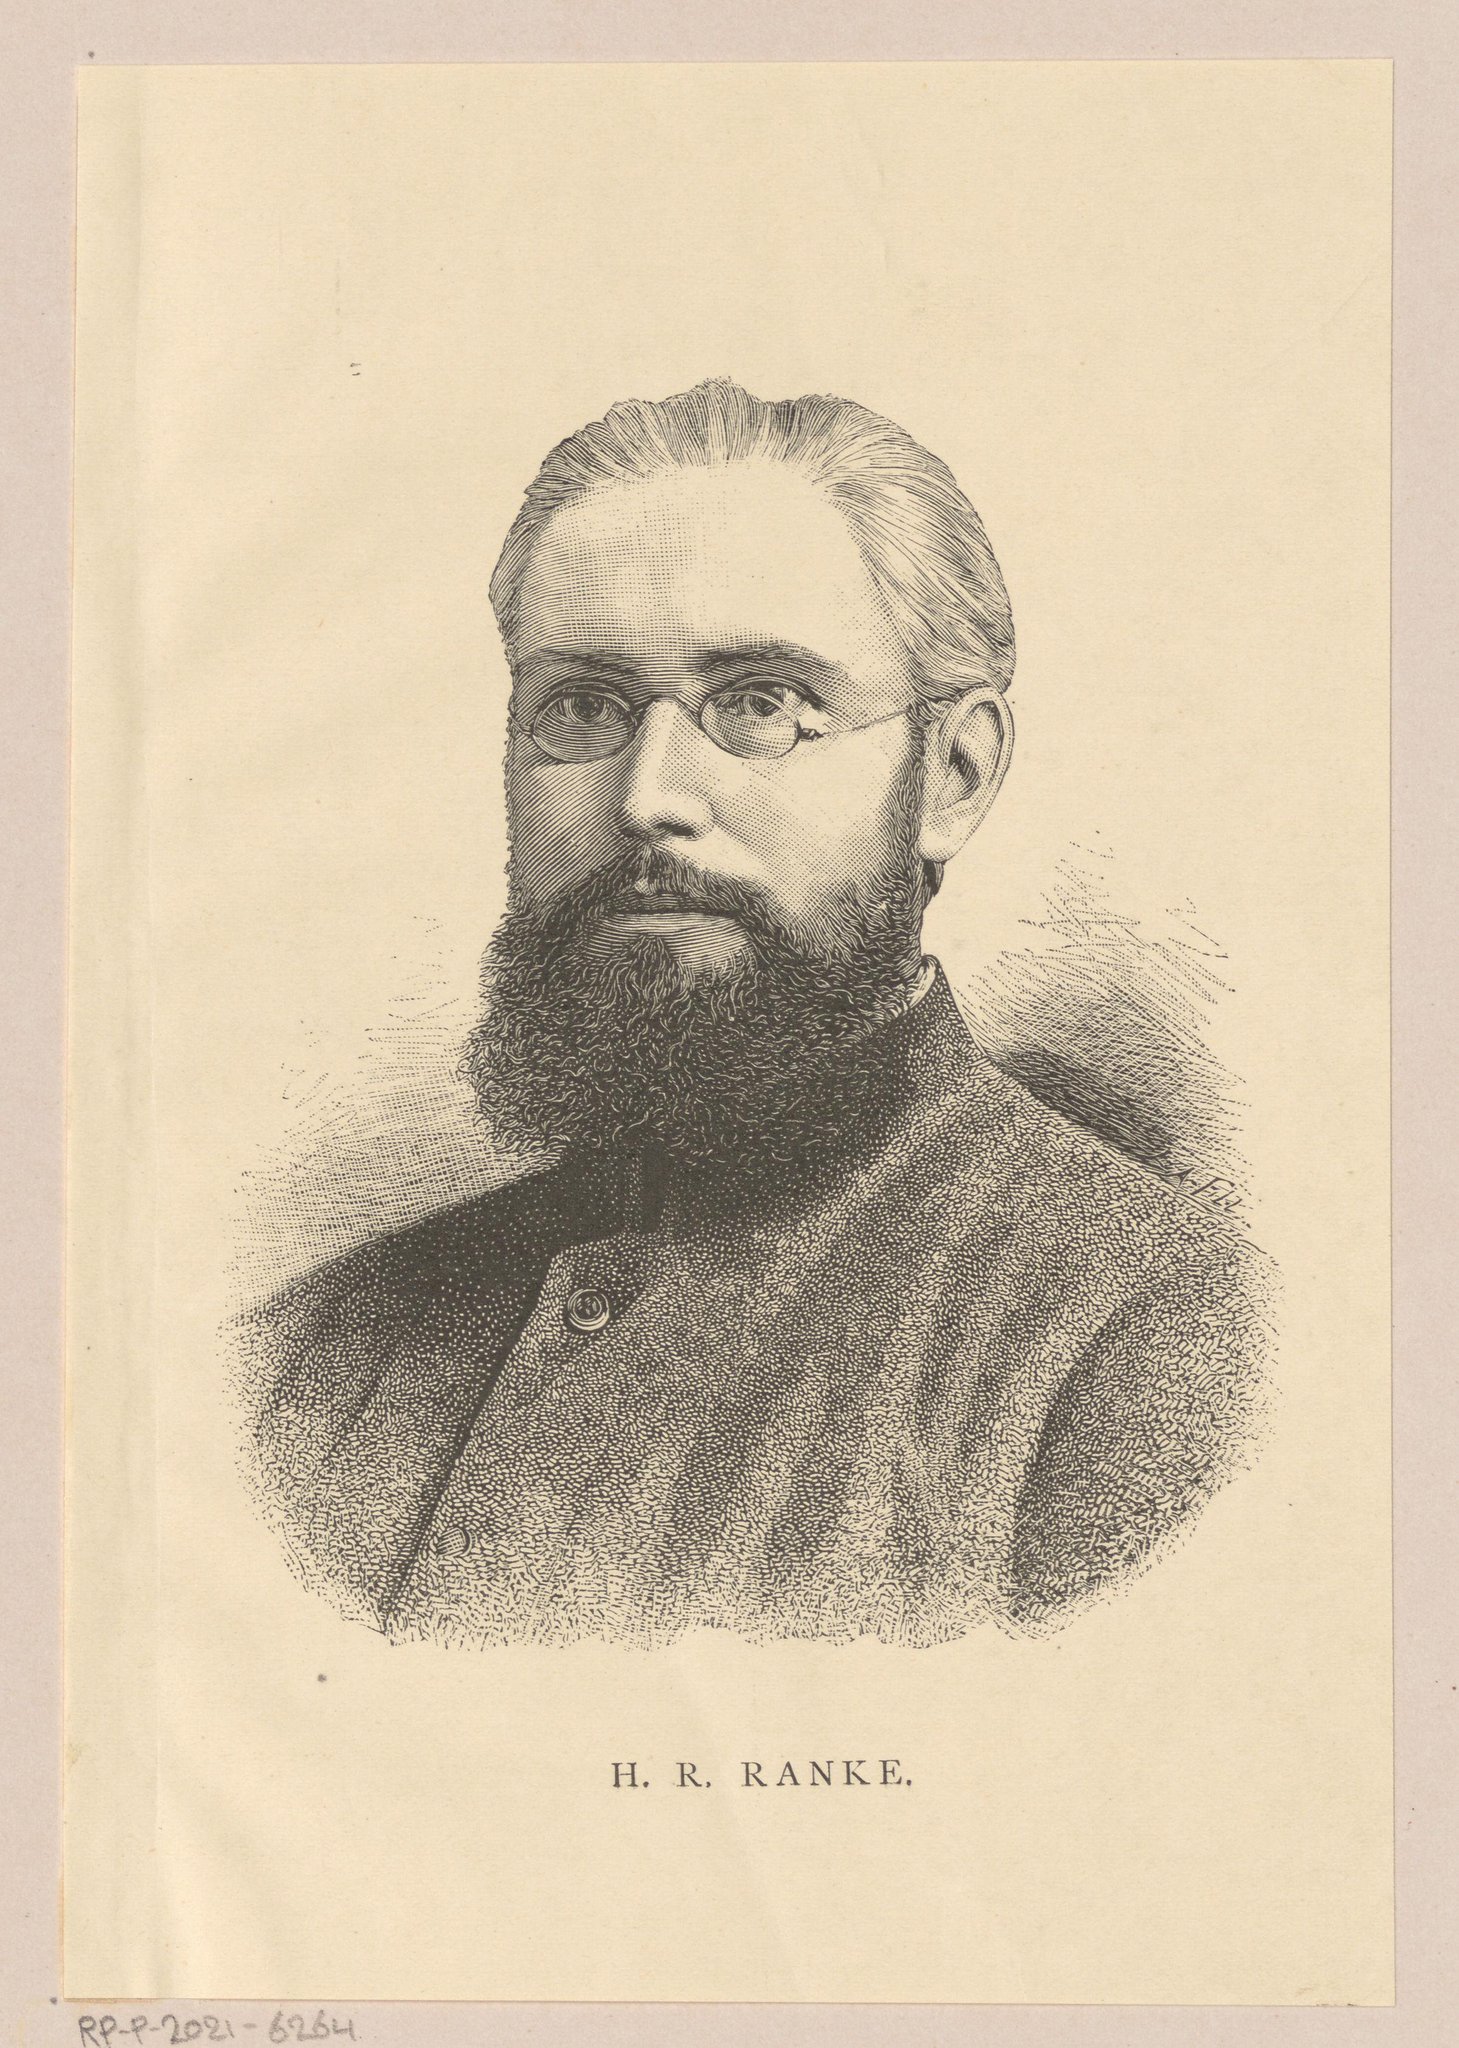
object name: print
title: Portret van Hans Rudolph Ranke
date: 1869-1898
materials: paper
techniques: engraving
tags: historical persons